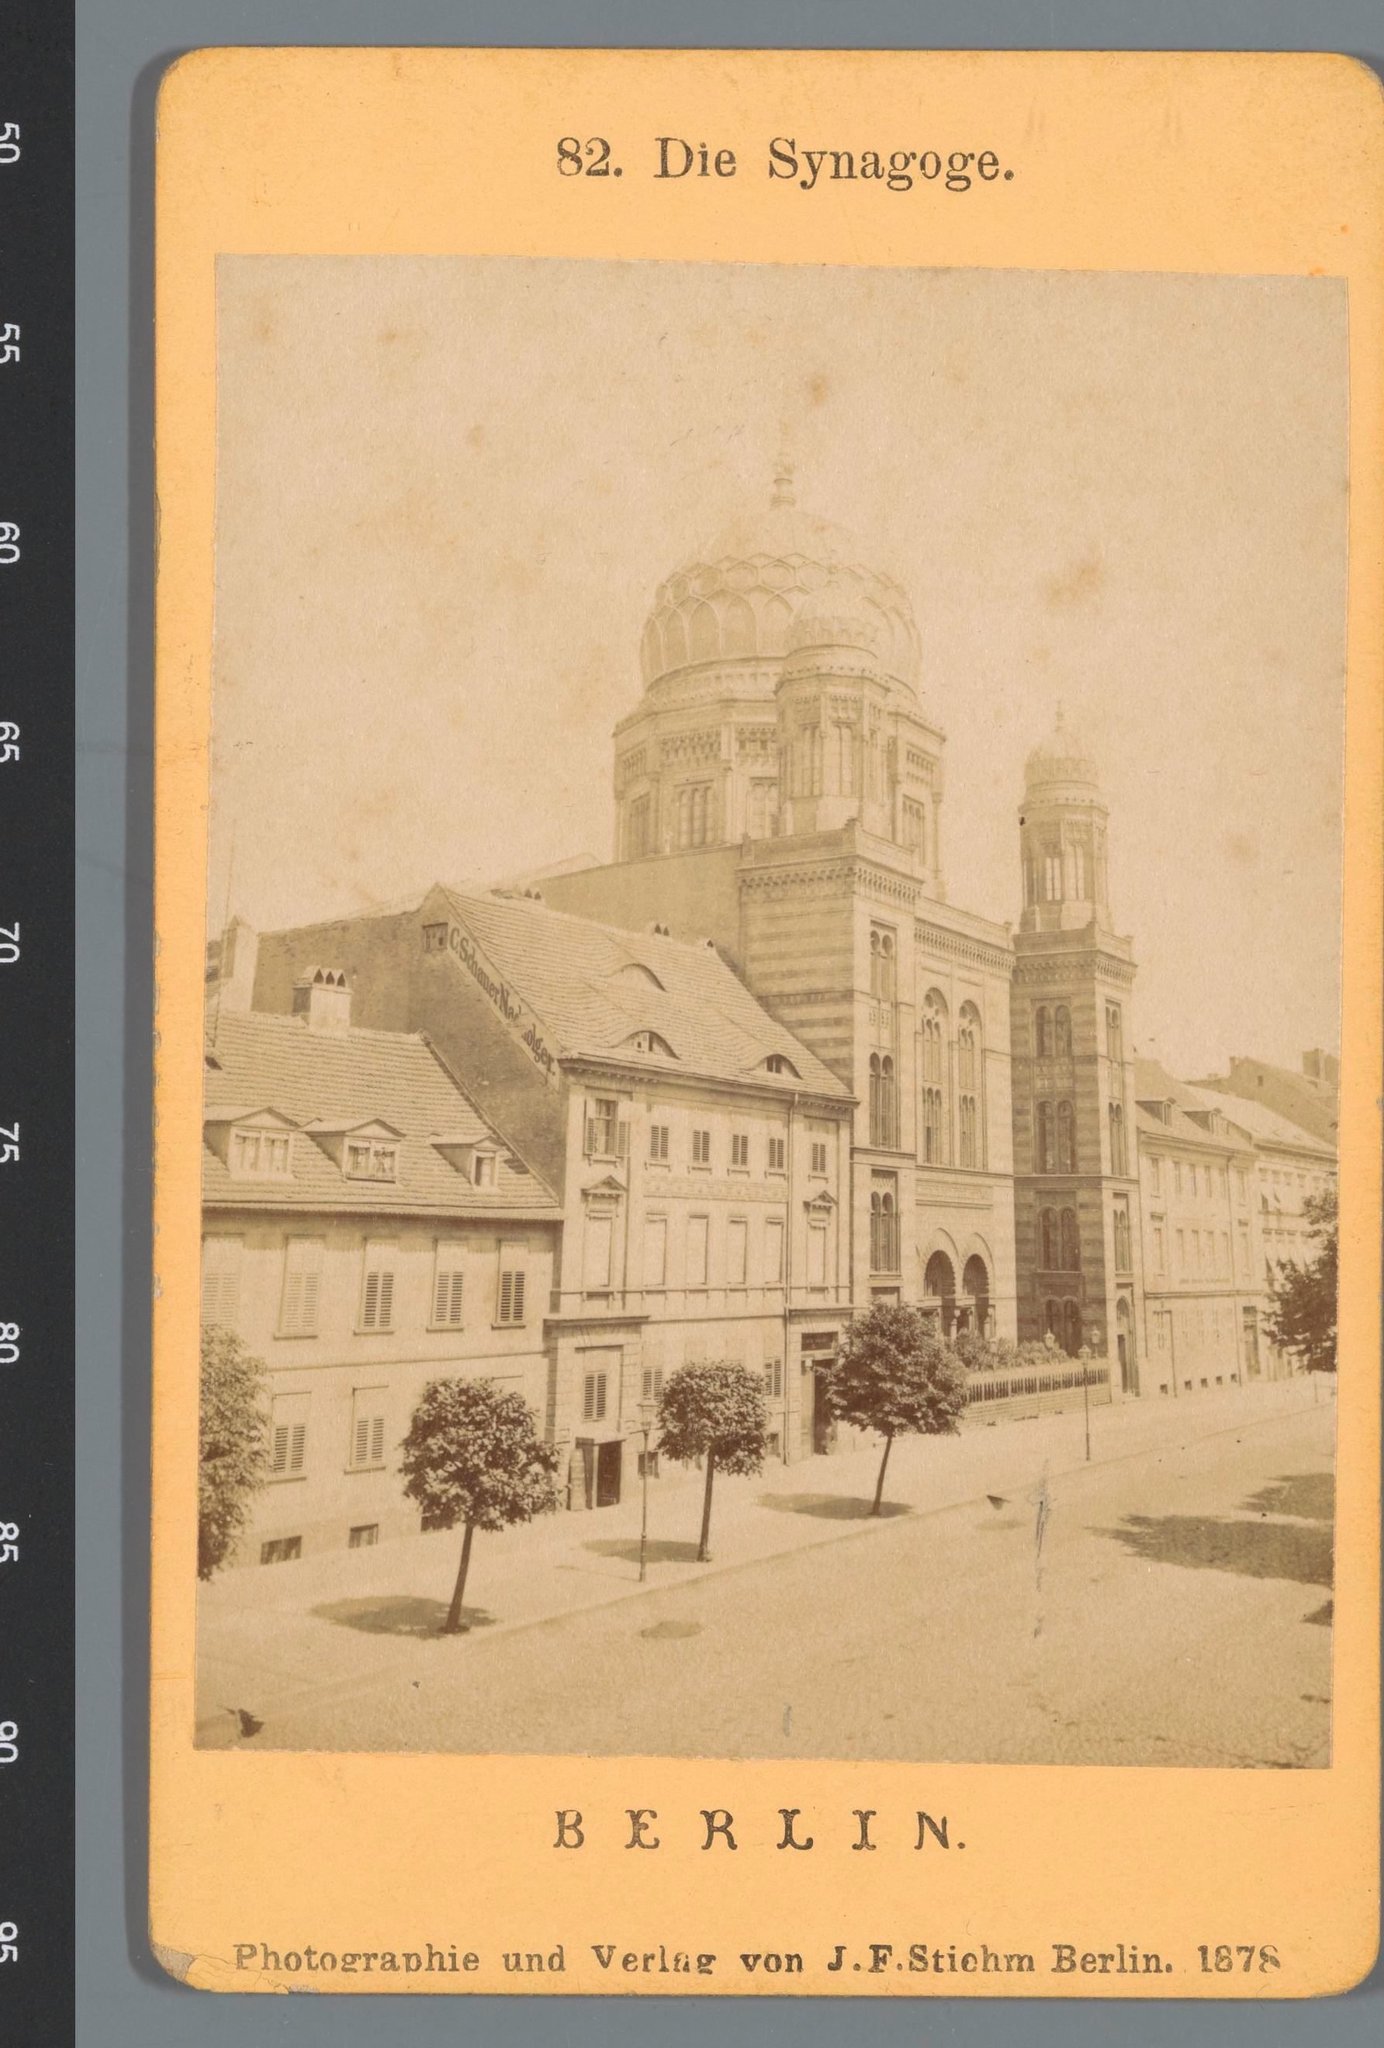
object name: carte de visite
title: Neue Synagoge aan de Oranienburger Straße, Berlijn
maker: johann friedrich stiehm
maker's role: fotograaf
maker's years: 1826-1902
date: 1878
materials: cardboard, paper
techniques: albumen print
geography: berlin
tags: the synagogue (as building and place of worship ~ jewish religion)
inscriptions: number: ‘82.’